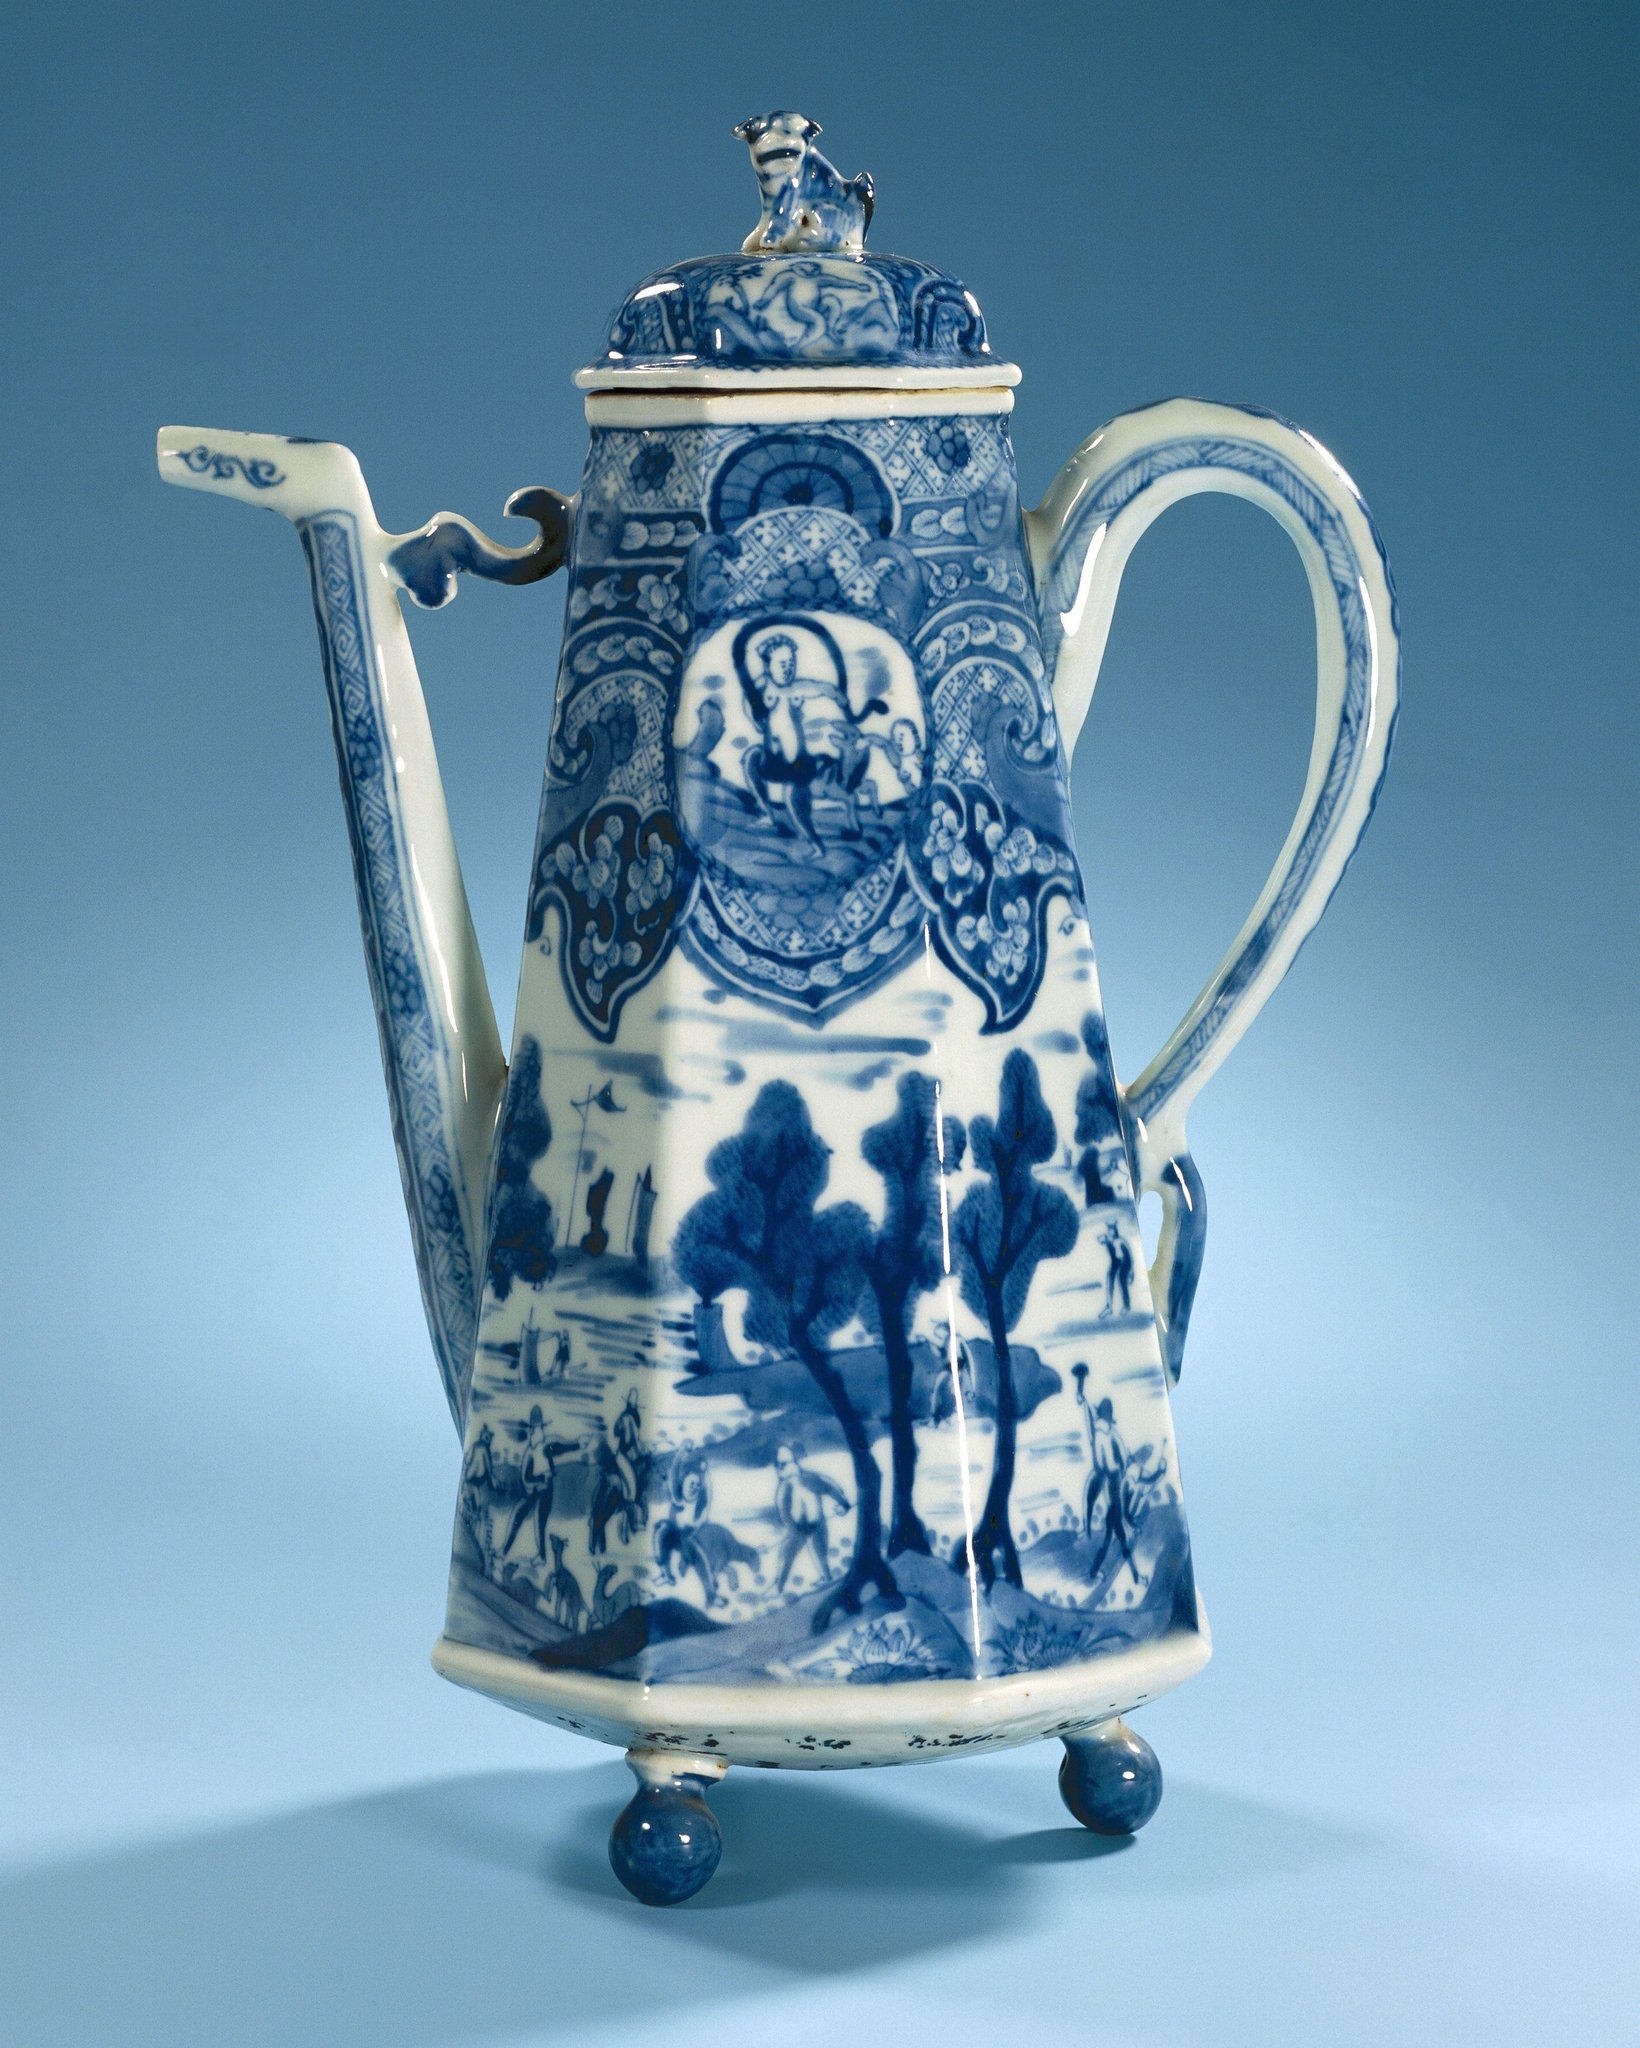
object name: coffee pot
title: Octagonal coffee pot with hunting and mythological scenes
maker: Anonymous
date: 1700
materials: cobalt, glaze, paint, porcelain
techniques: firing, forming, turning, vitrification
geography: china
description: Achthoekige koffiepot op drie bolle pootjes met oor en tuit. Het lichaam heeft strakke, rechte zijden, naar boven toe smal toelopend. De tuit, die op het einde naar buiten is gebogen, is met een verbindingsstukje bevestigd aan het lichaam. Op de pot een gewelfd deksel met daarop een leeuw. Gedecoreerd in onderglazuur blauw. De decoratie is aangebracht in twee gedeelten, beide met een Europese voorstelling. Het onderste gedeelte toont een landschap met een jachtgezelschap, het bovenste gedeelte twee cartouches met de voorstelling van Europa en de stier. Aan het eind van de 17de eeuw was het koffiedrinken zeer populair geworden in Europa, en hierdoor ontstond er een grote vraag naar porseleinen serviesgoed. De eerste koffiepotten, met deze vorm waren afgeleid van Europese modellen. De kannen komen ook voor in Delfts aardewerk, waarvan een exemplaar in het bezit van het Rijksmuseum is. De koffiepotten waren voor de Chinese pottenbakkers moeilijk te produceren vanwege hun conische vorm en strakke hoeken en zijden, en werden derhalve al snel vervangen door ronde conische modellen. Alle bekende potten zijn vervaardigd in onderglazuur blauw, er zijn geen polychrome exemplaren bekend met emails op het glazuur.